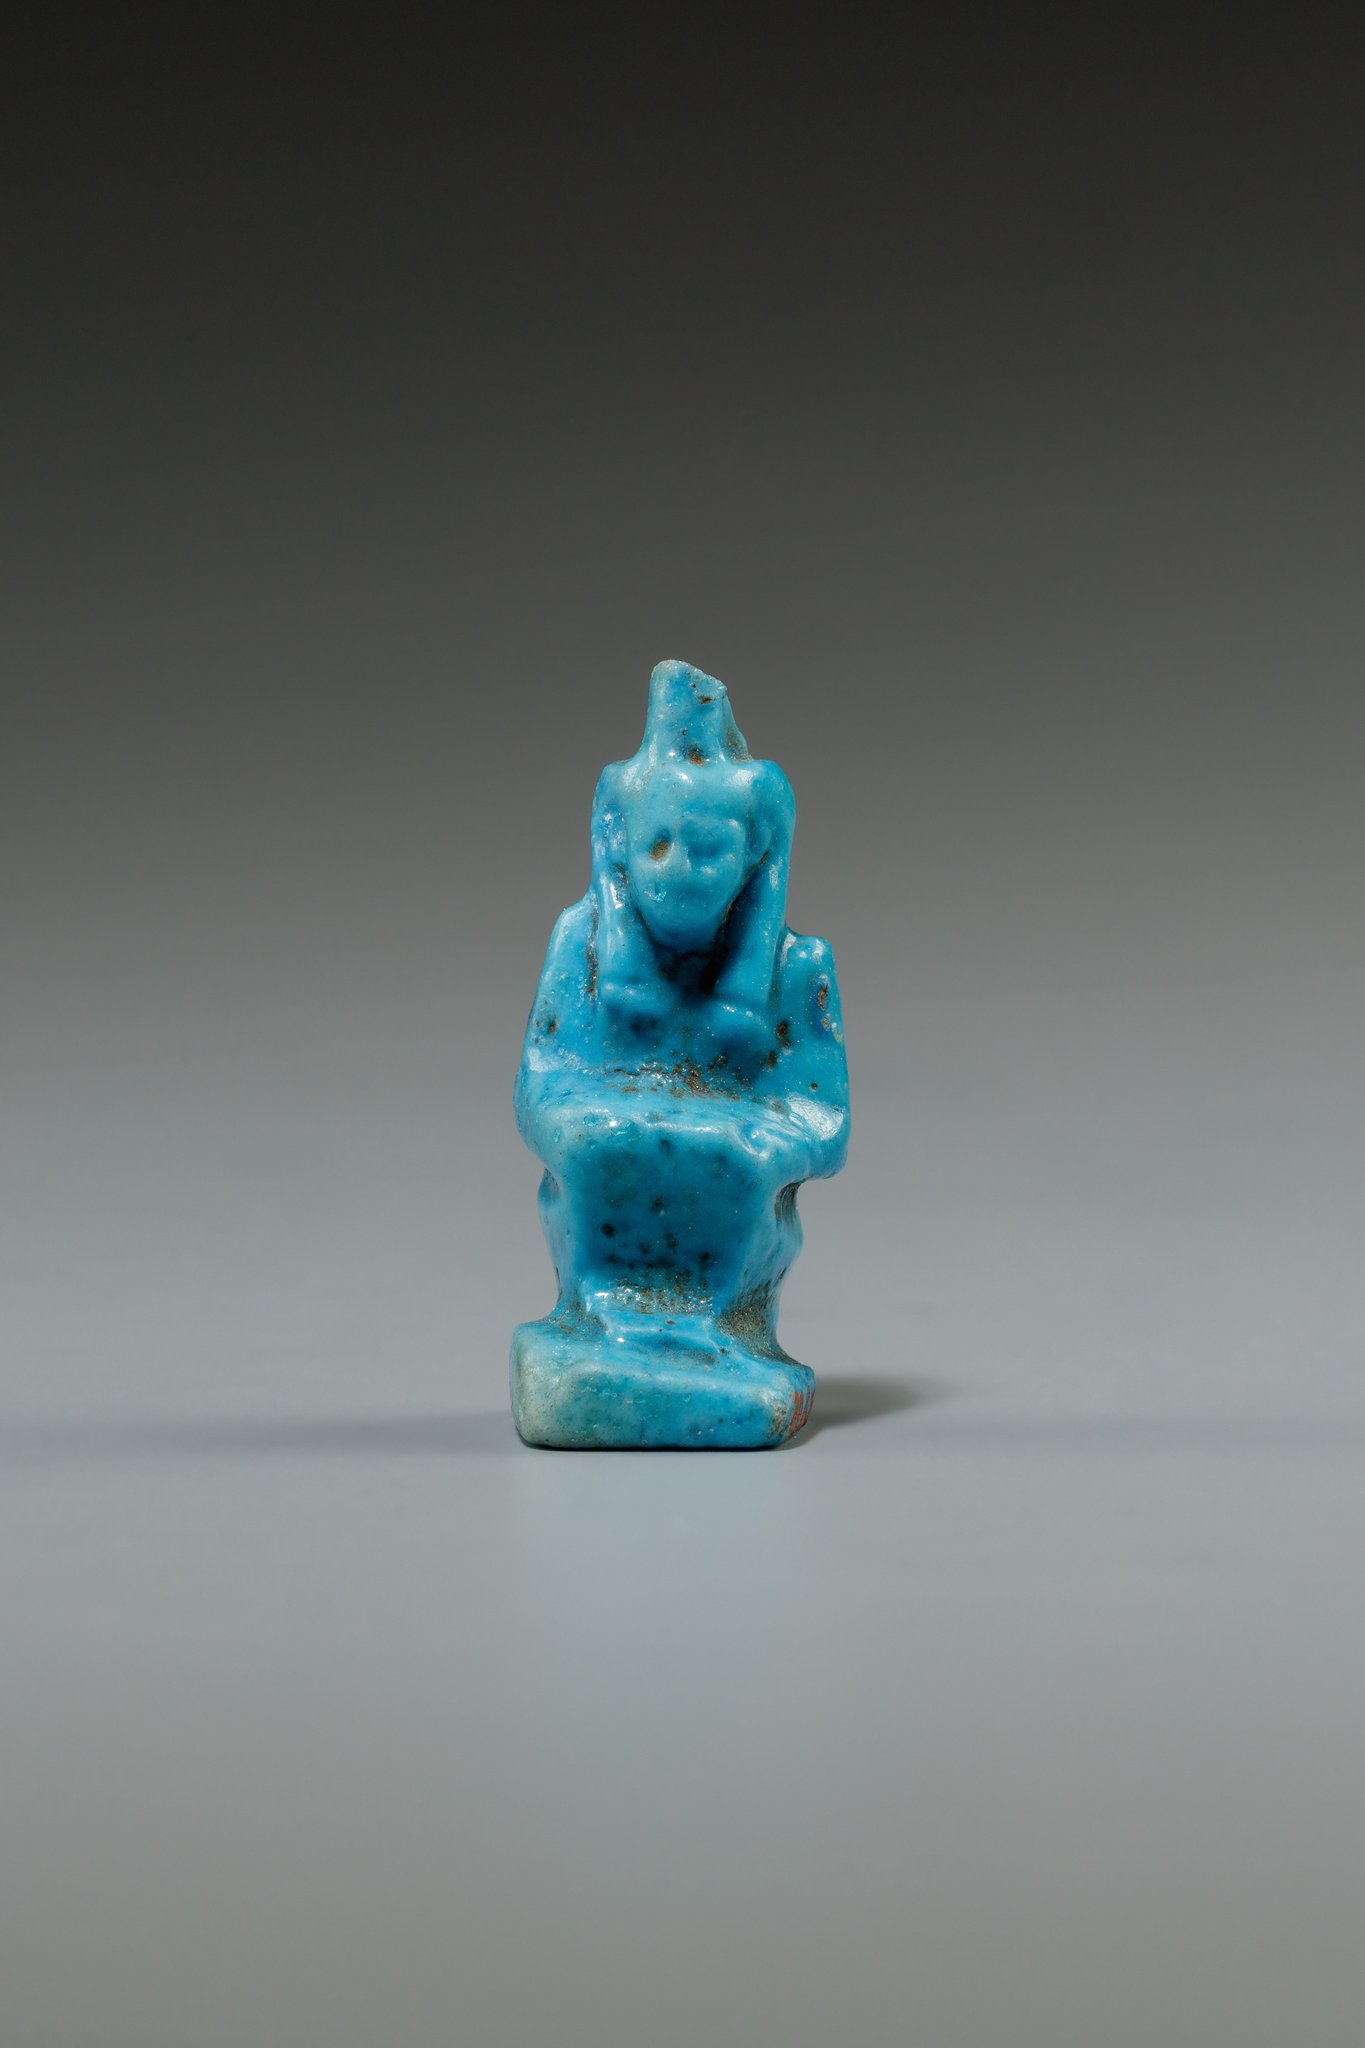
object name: amulet, maat seated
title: Maat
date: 664-630 BCE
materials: faience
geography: egypt